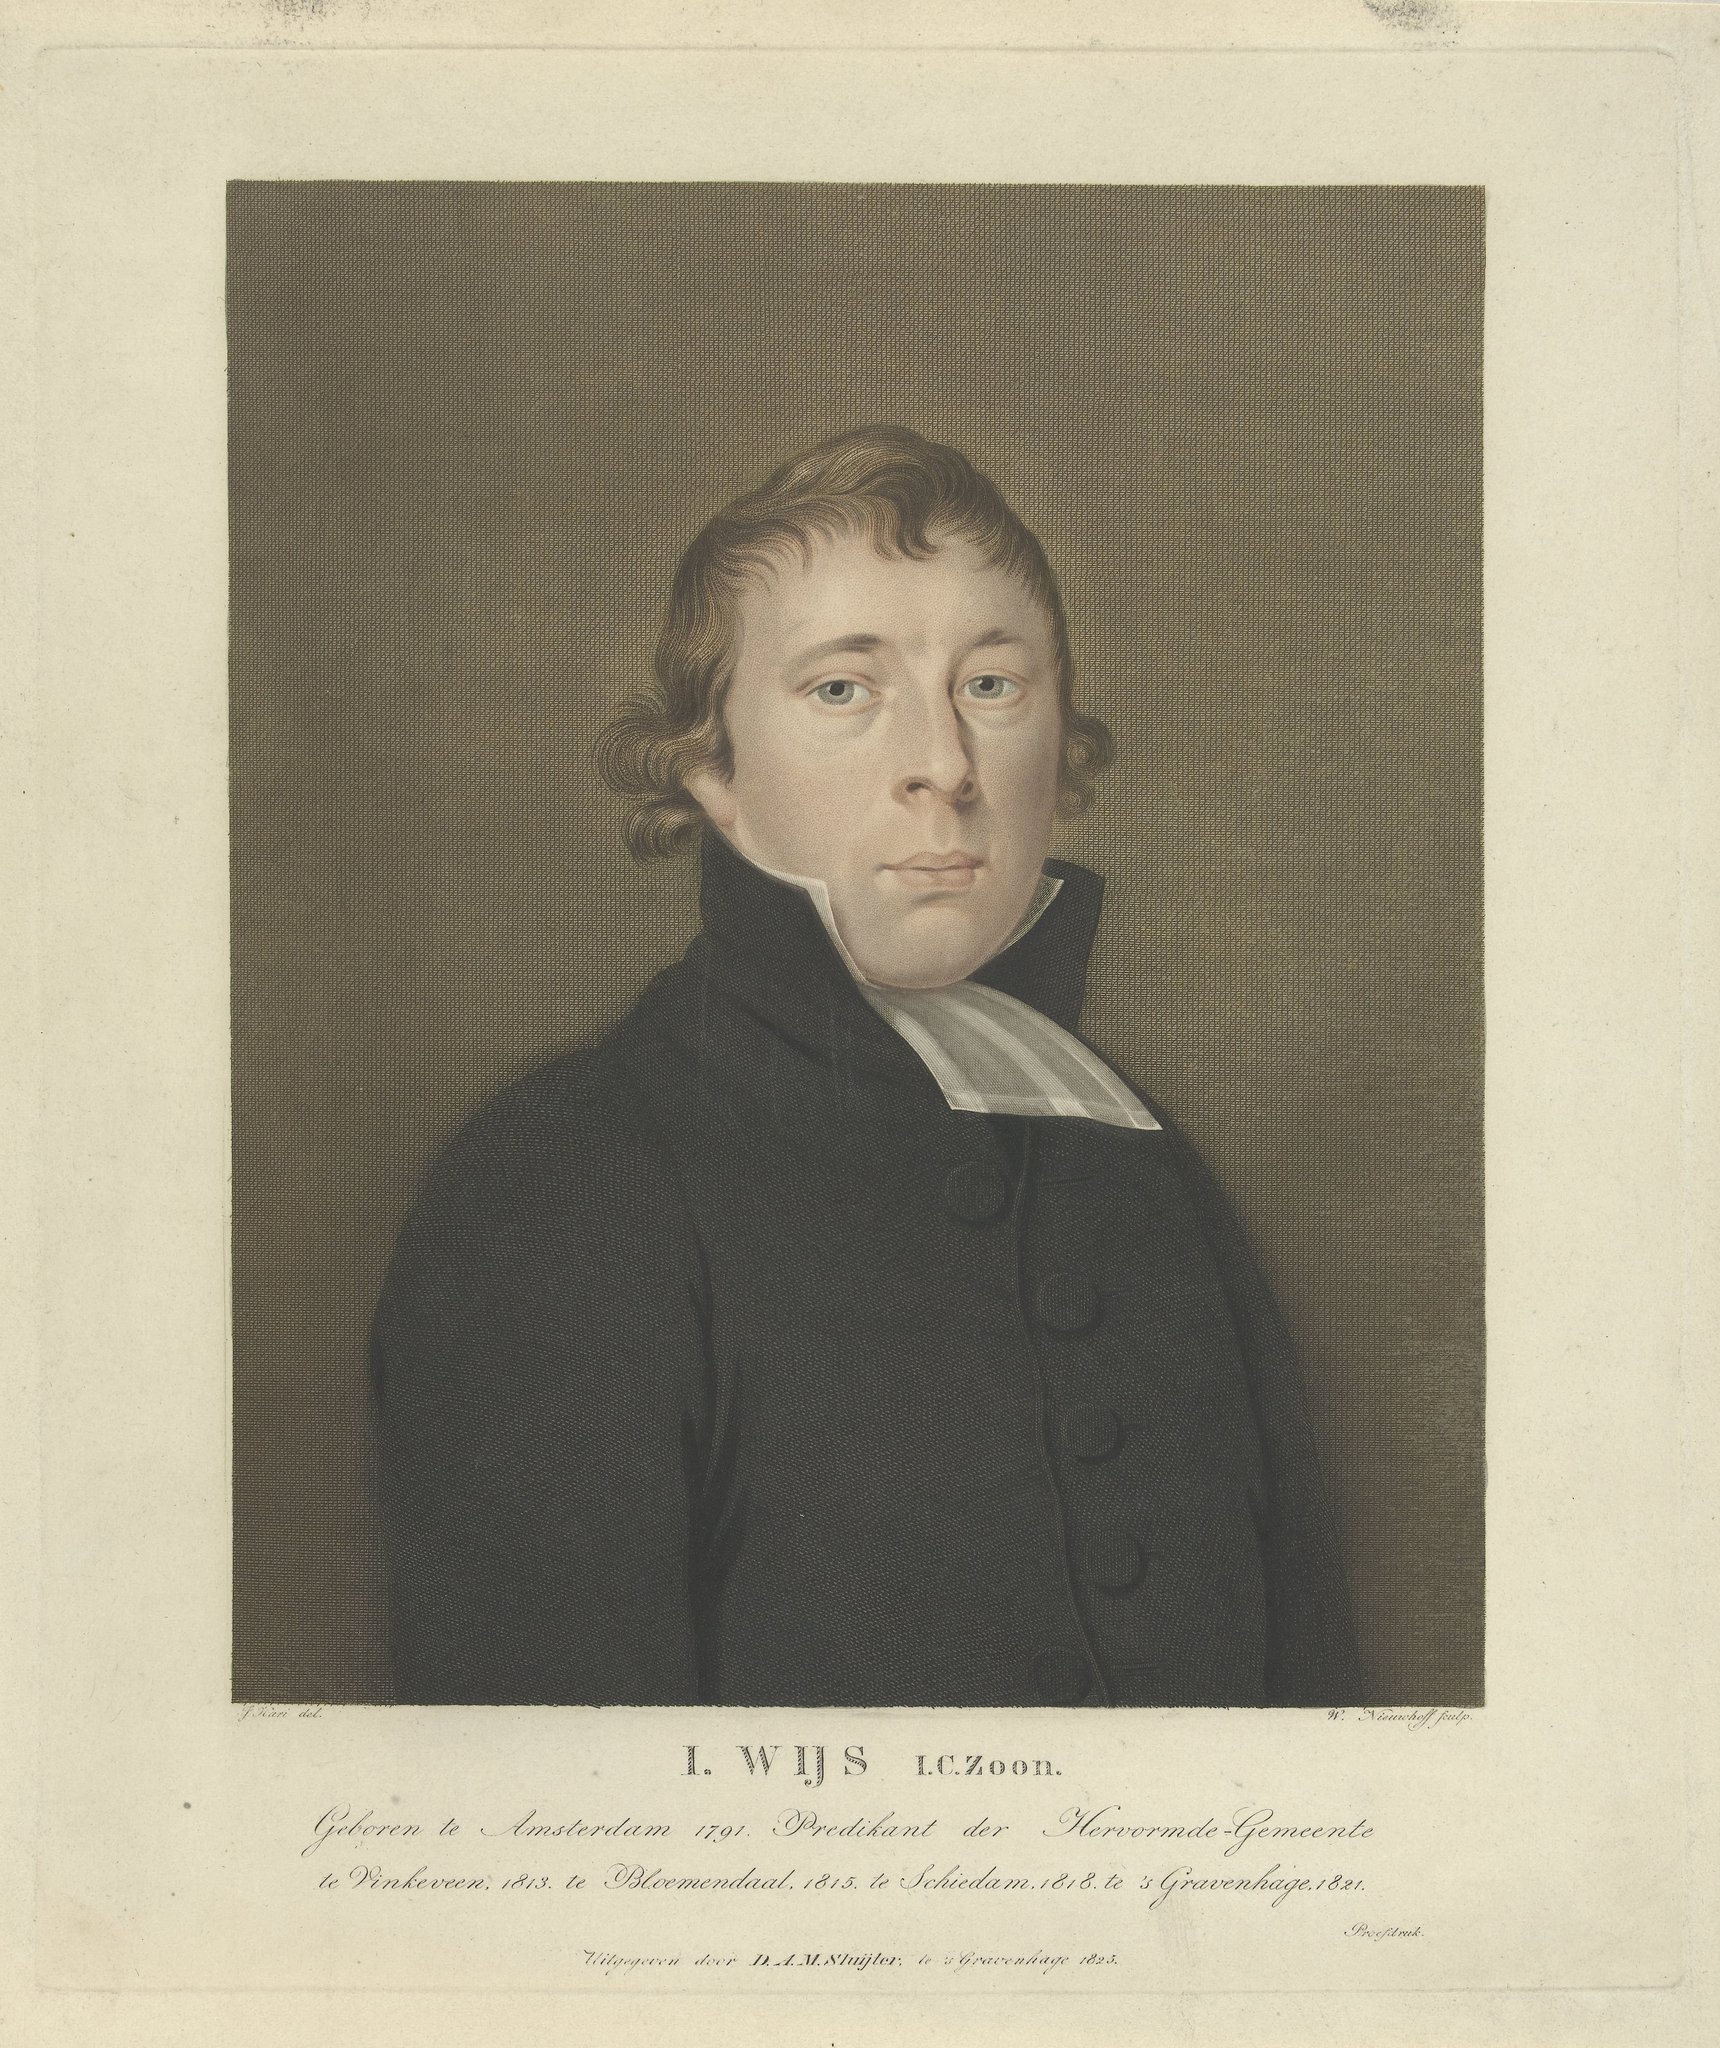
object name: print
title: I. Wijs I.C. Zoon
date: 1825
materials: paper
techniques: engraving, hand coloring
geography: the hague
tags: amsterdam, the hague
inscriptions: collector's mark: Lugt 2228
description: Buste van Jacob Wijs, hervormd predikant te Den Haag, naar rechts. Onderaan in de marge een tweeregelige tekst in het Nederlands.